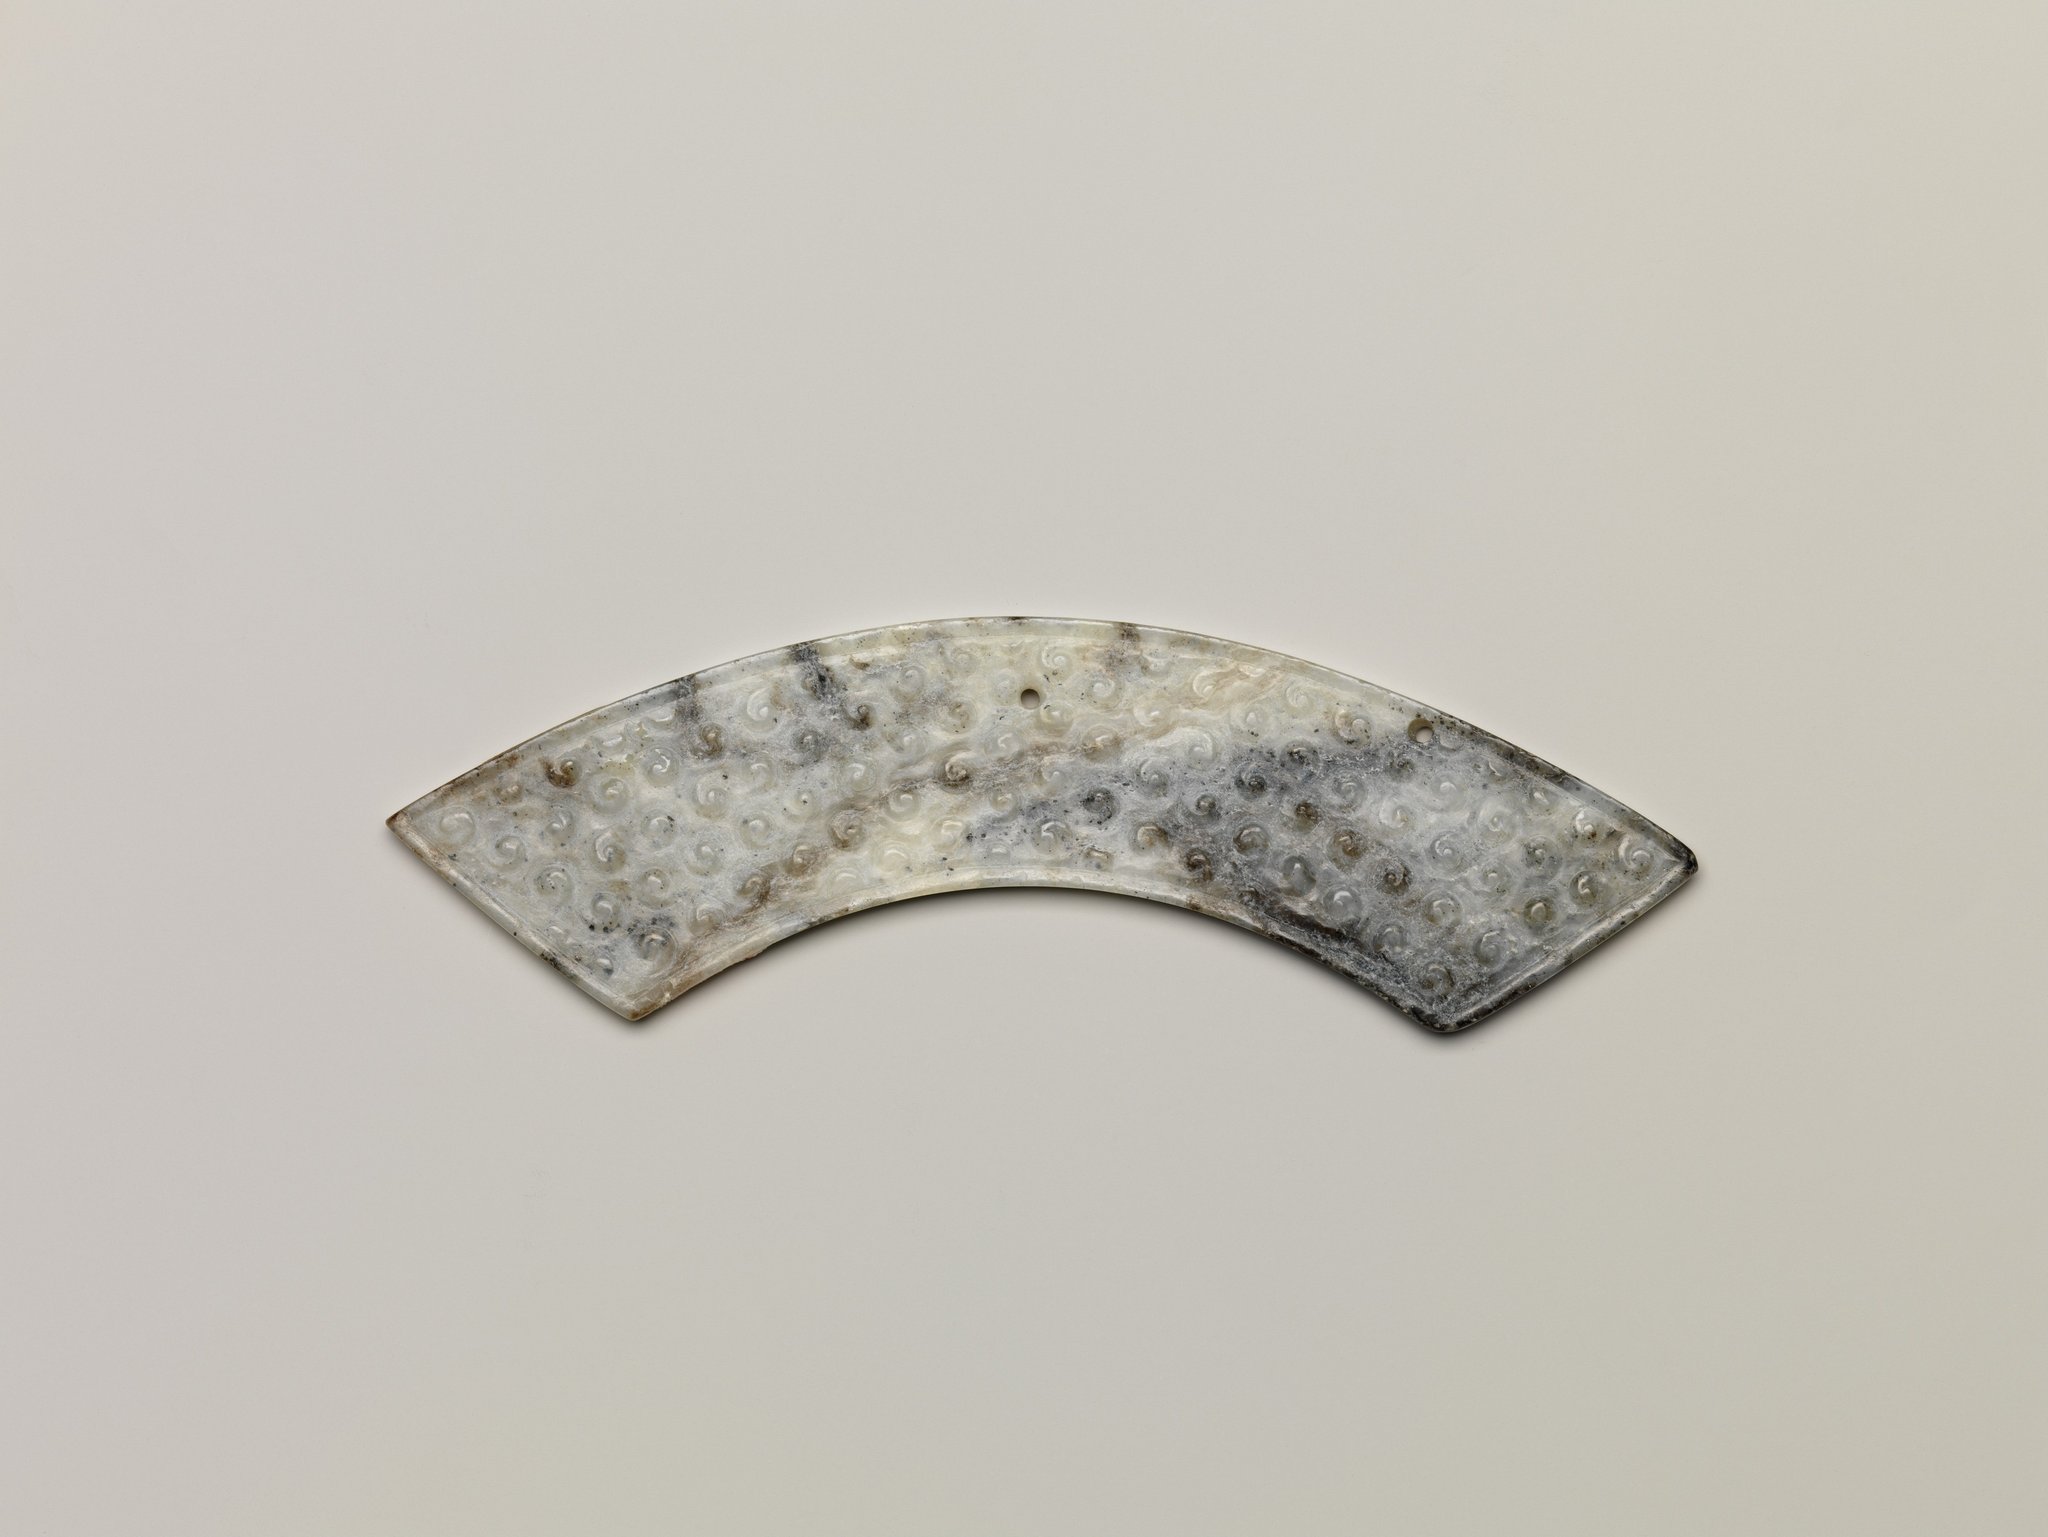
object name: pendant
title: Arc-shaped pendant (Huang)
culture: chinese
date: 500-401 BCE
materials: jade